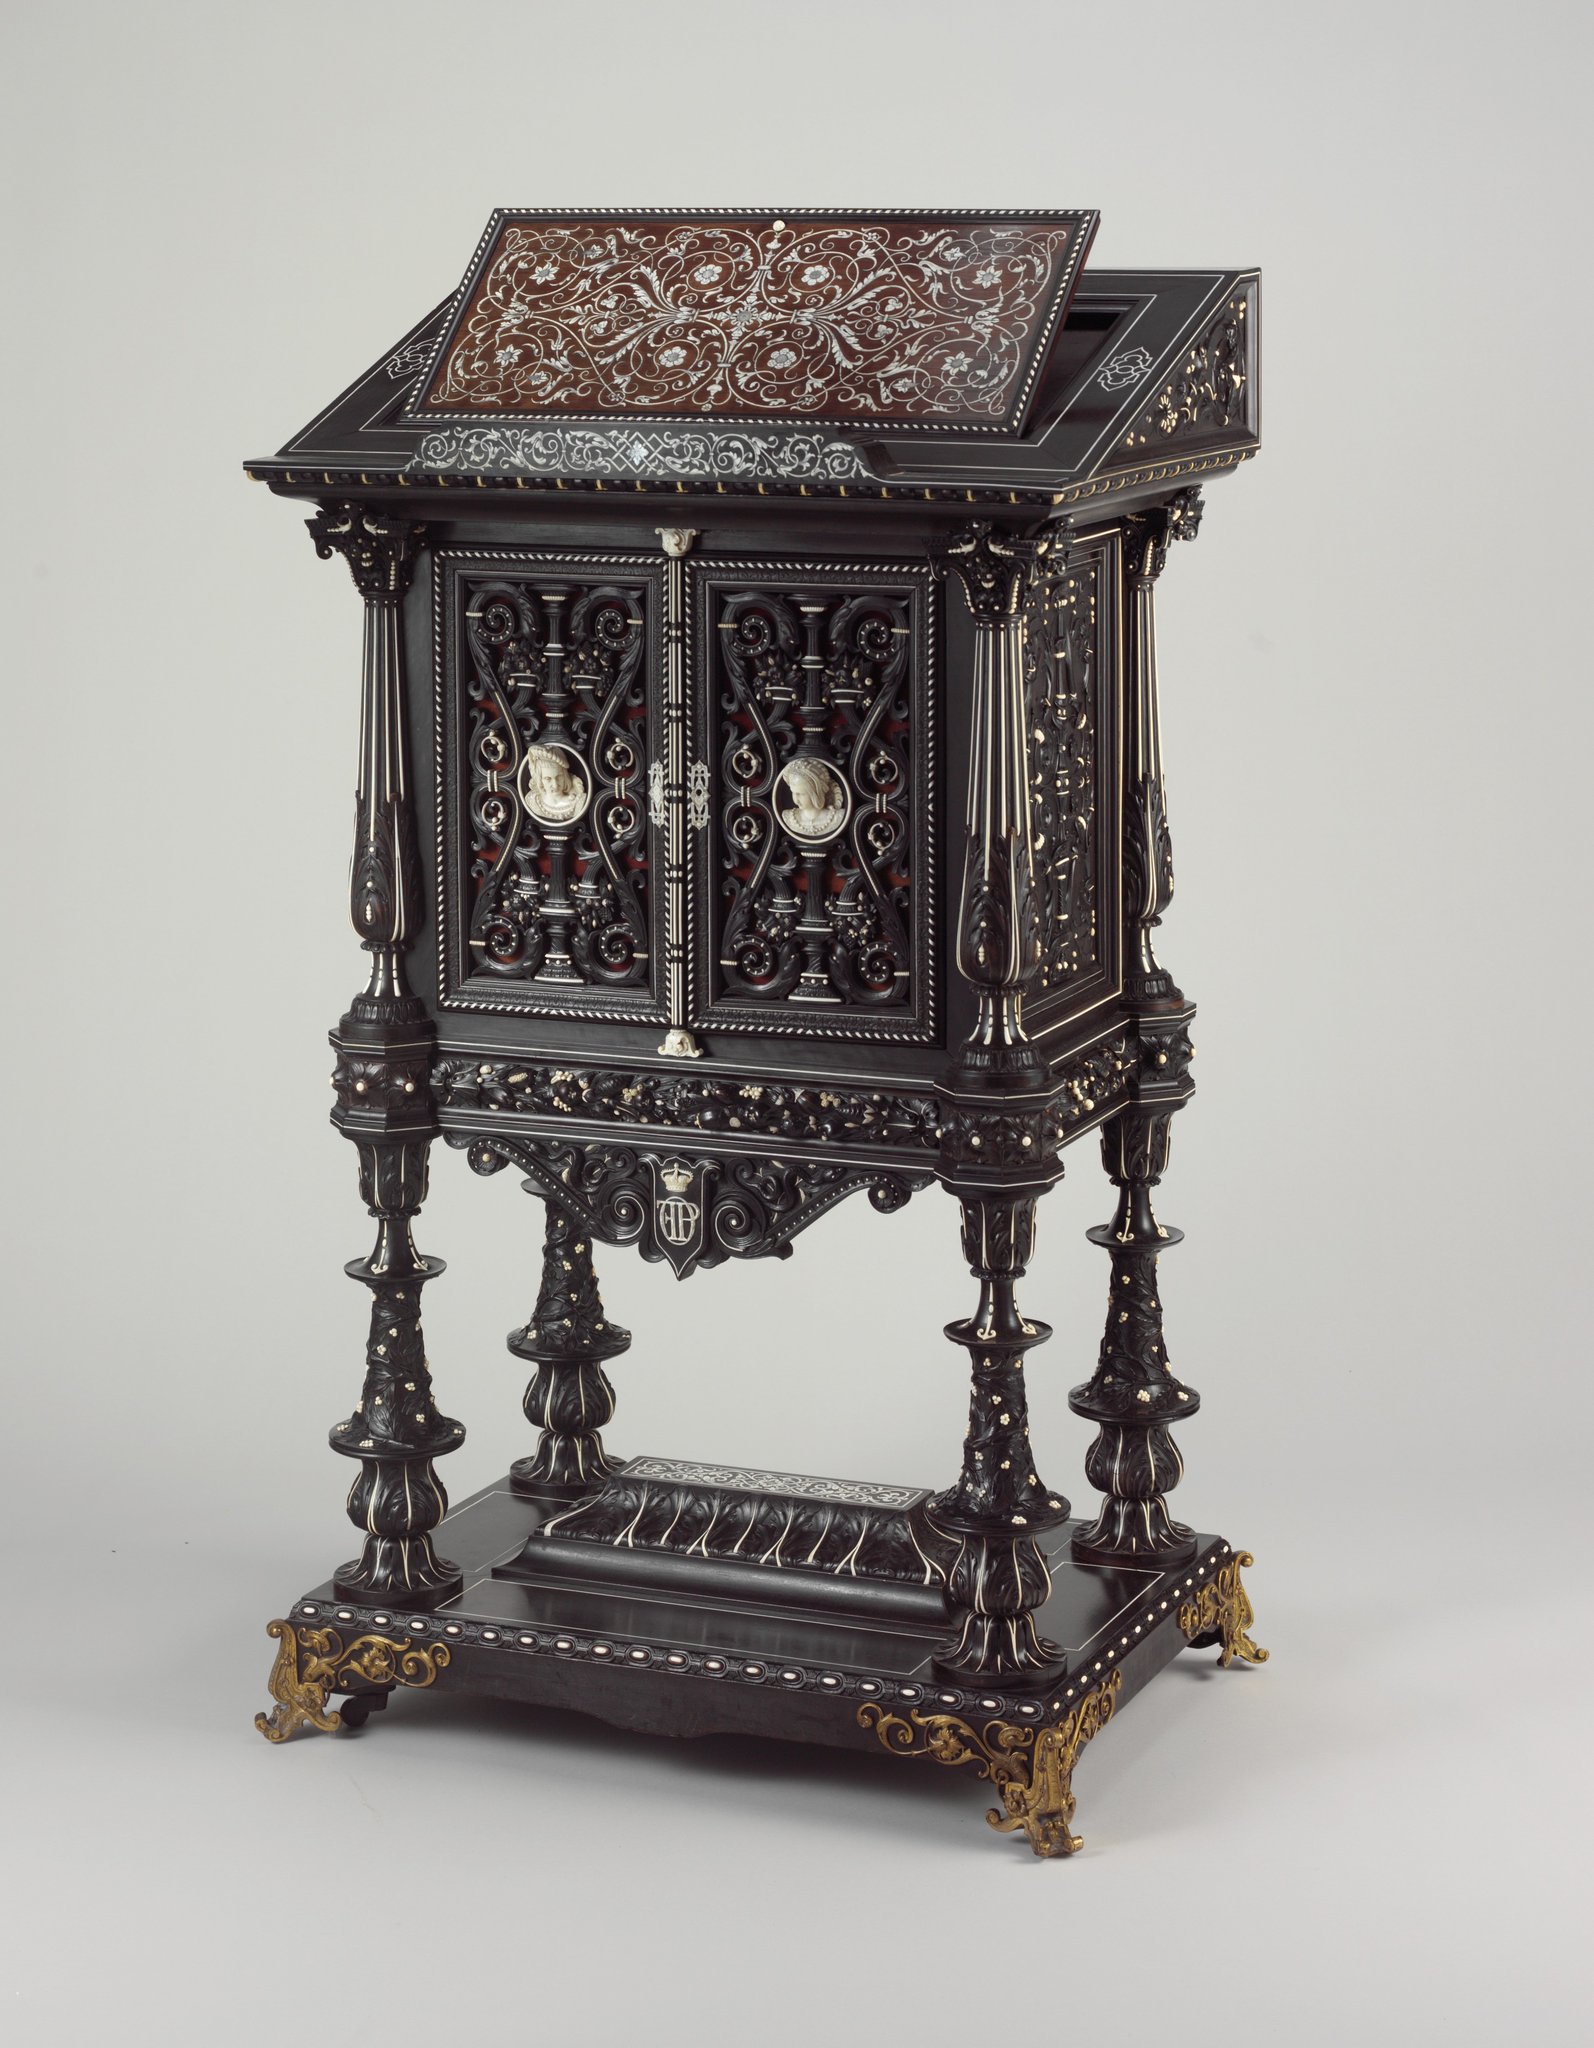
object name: bookstand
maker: charles-auguste questel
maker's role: designer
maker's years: 1807-1888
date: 1839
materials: brass, wood, ivory, mother of pearl, silk, velvet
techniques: veneering